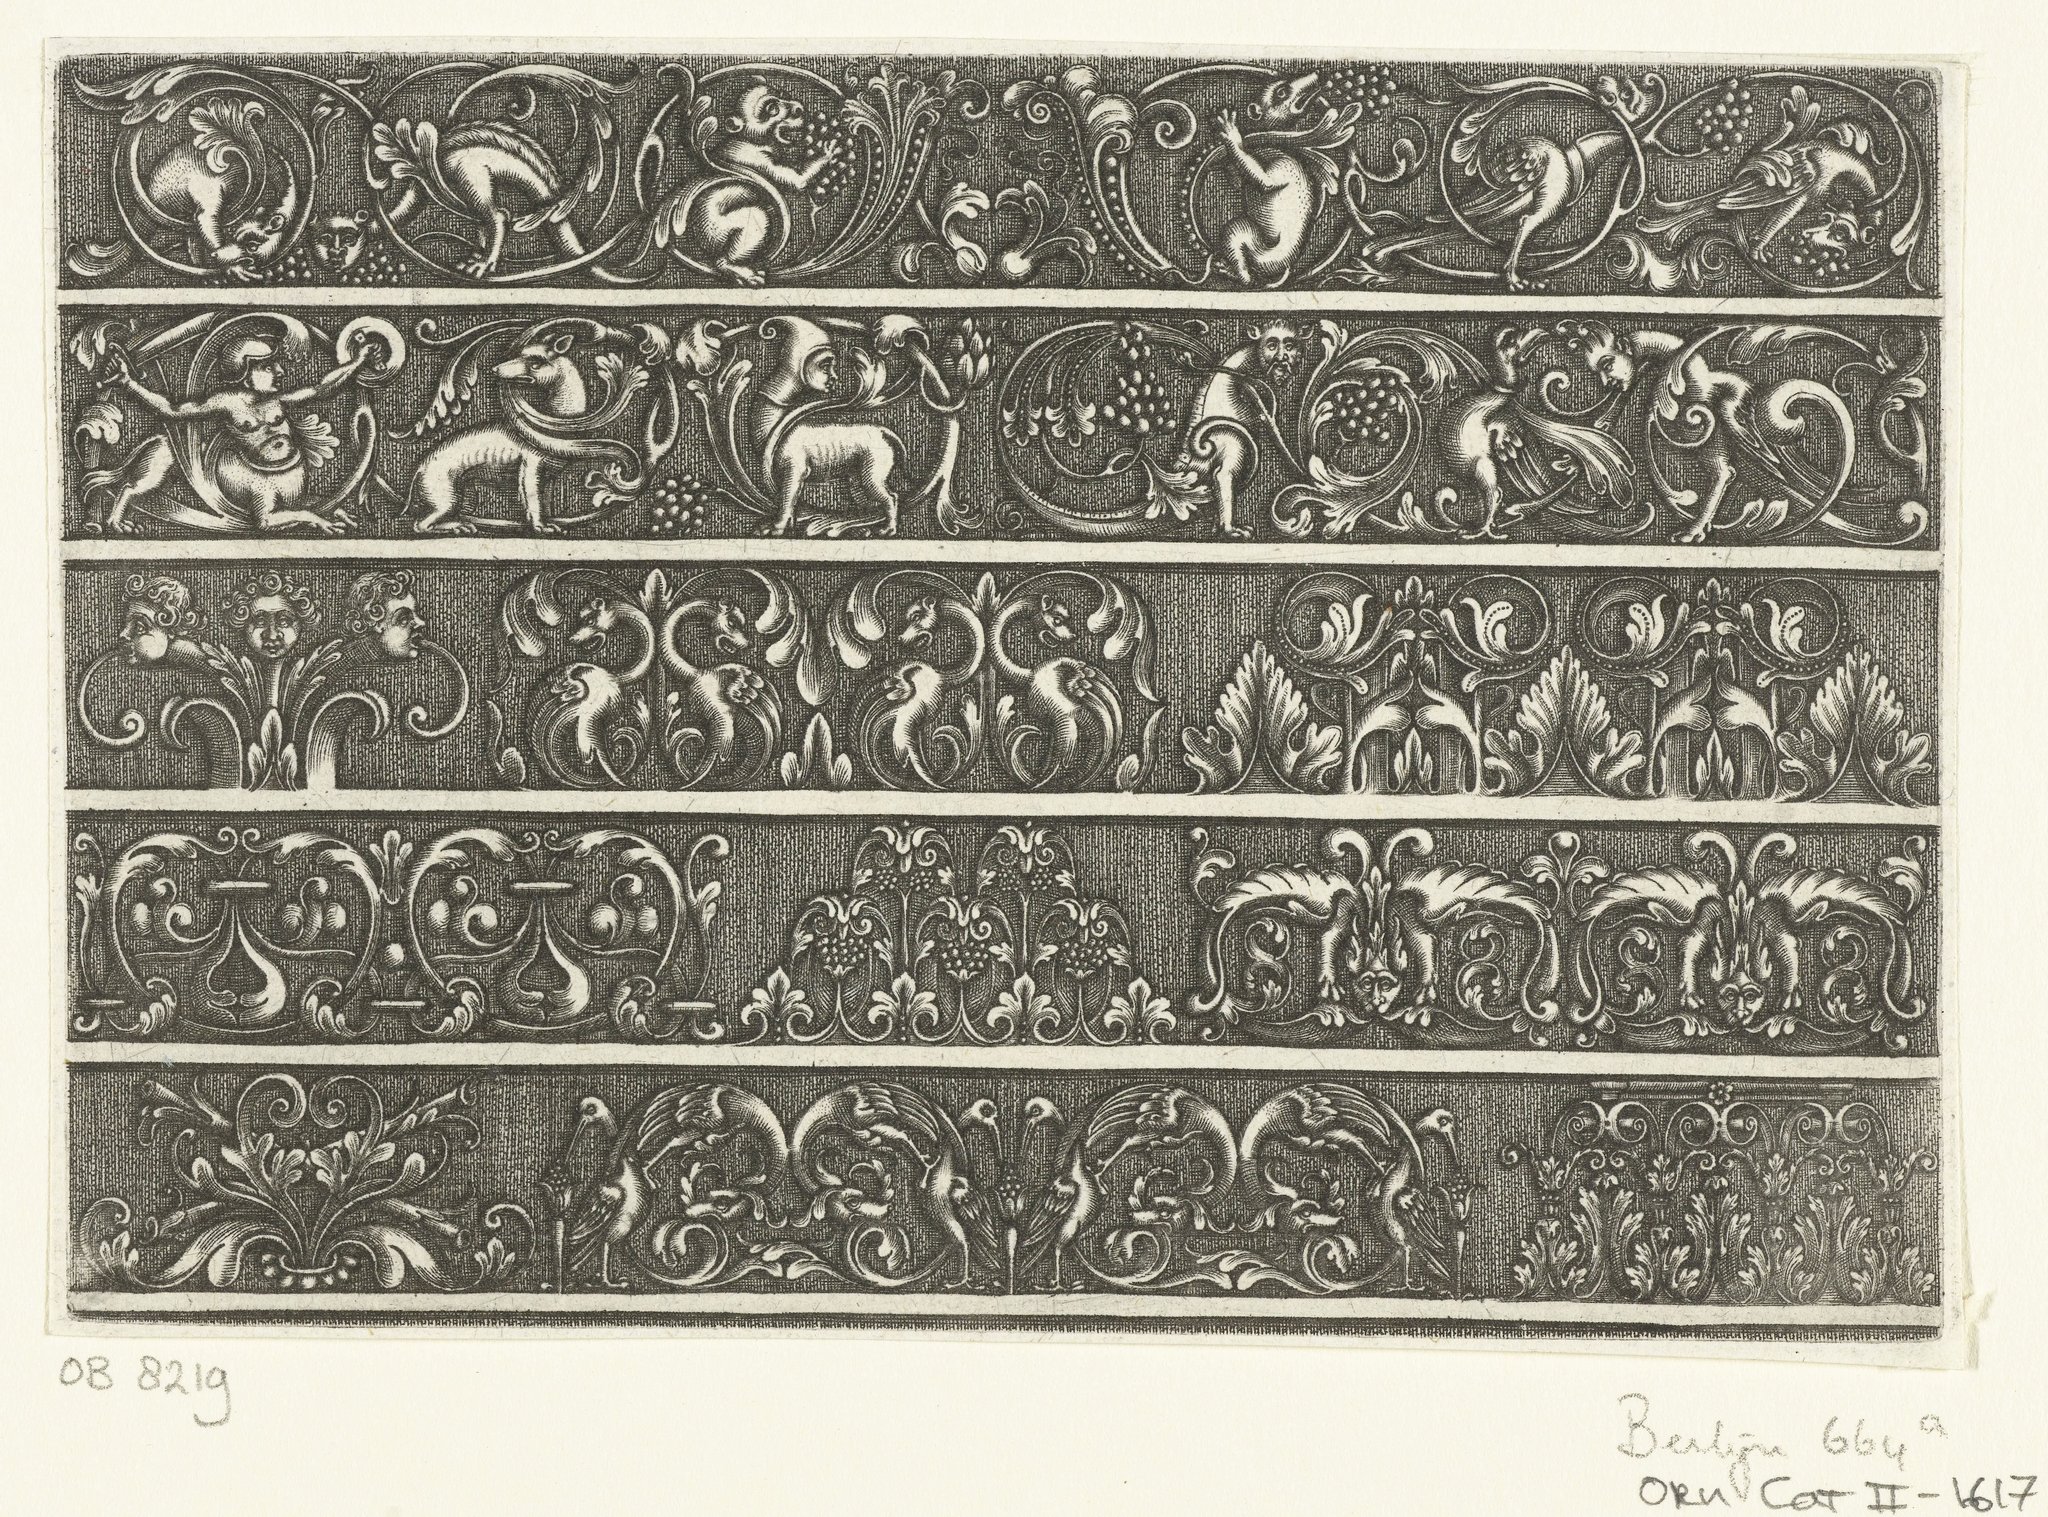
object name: print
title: Zierhat boichilgen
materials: paper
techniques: engraving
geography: cologne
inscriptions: collector's mark: Lugt 240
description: De ornamenten bestaan voornamelijk uit gestileerde bladranken met dieren en druiventrossen.